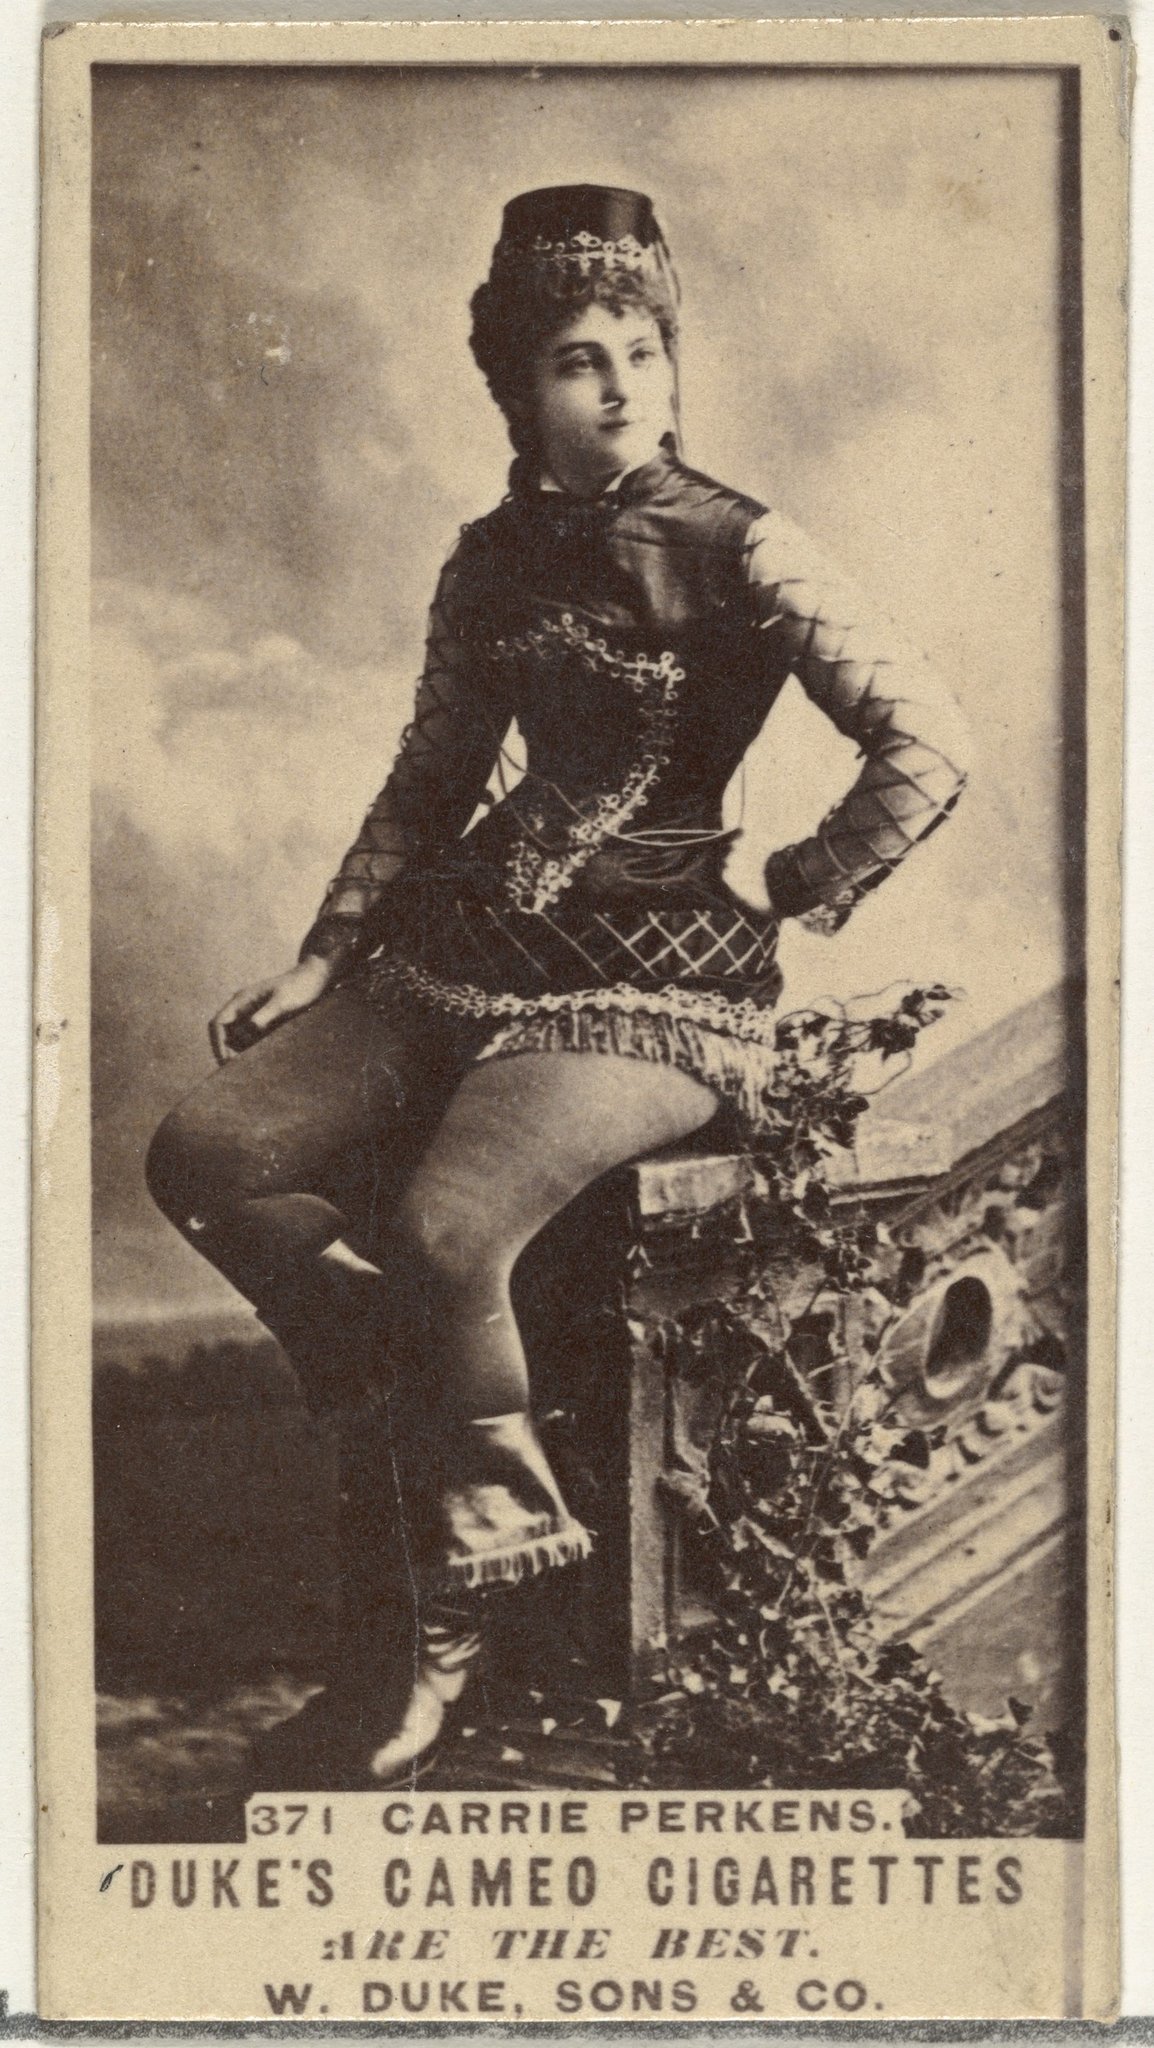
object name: photograph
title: Card Number 371, Carrie Perkens, from the Actors and Actresses series (N145-5) issued by Duke Sons & Co. to promote Cameo Cigarettes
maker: w. duke, sons & co.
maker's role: publisher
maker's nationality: american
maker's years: 1870-1920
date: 1880-1889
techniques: albumen silver print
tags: portraits,women,actresses